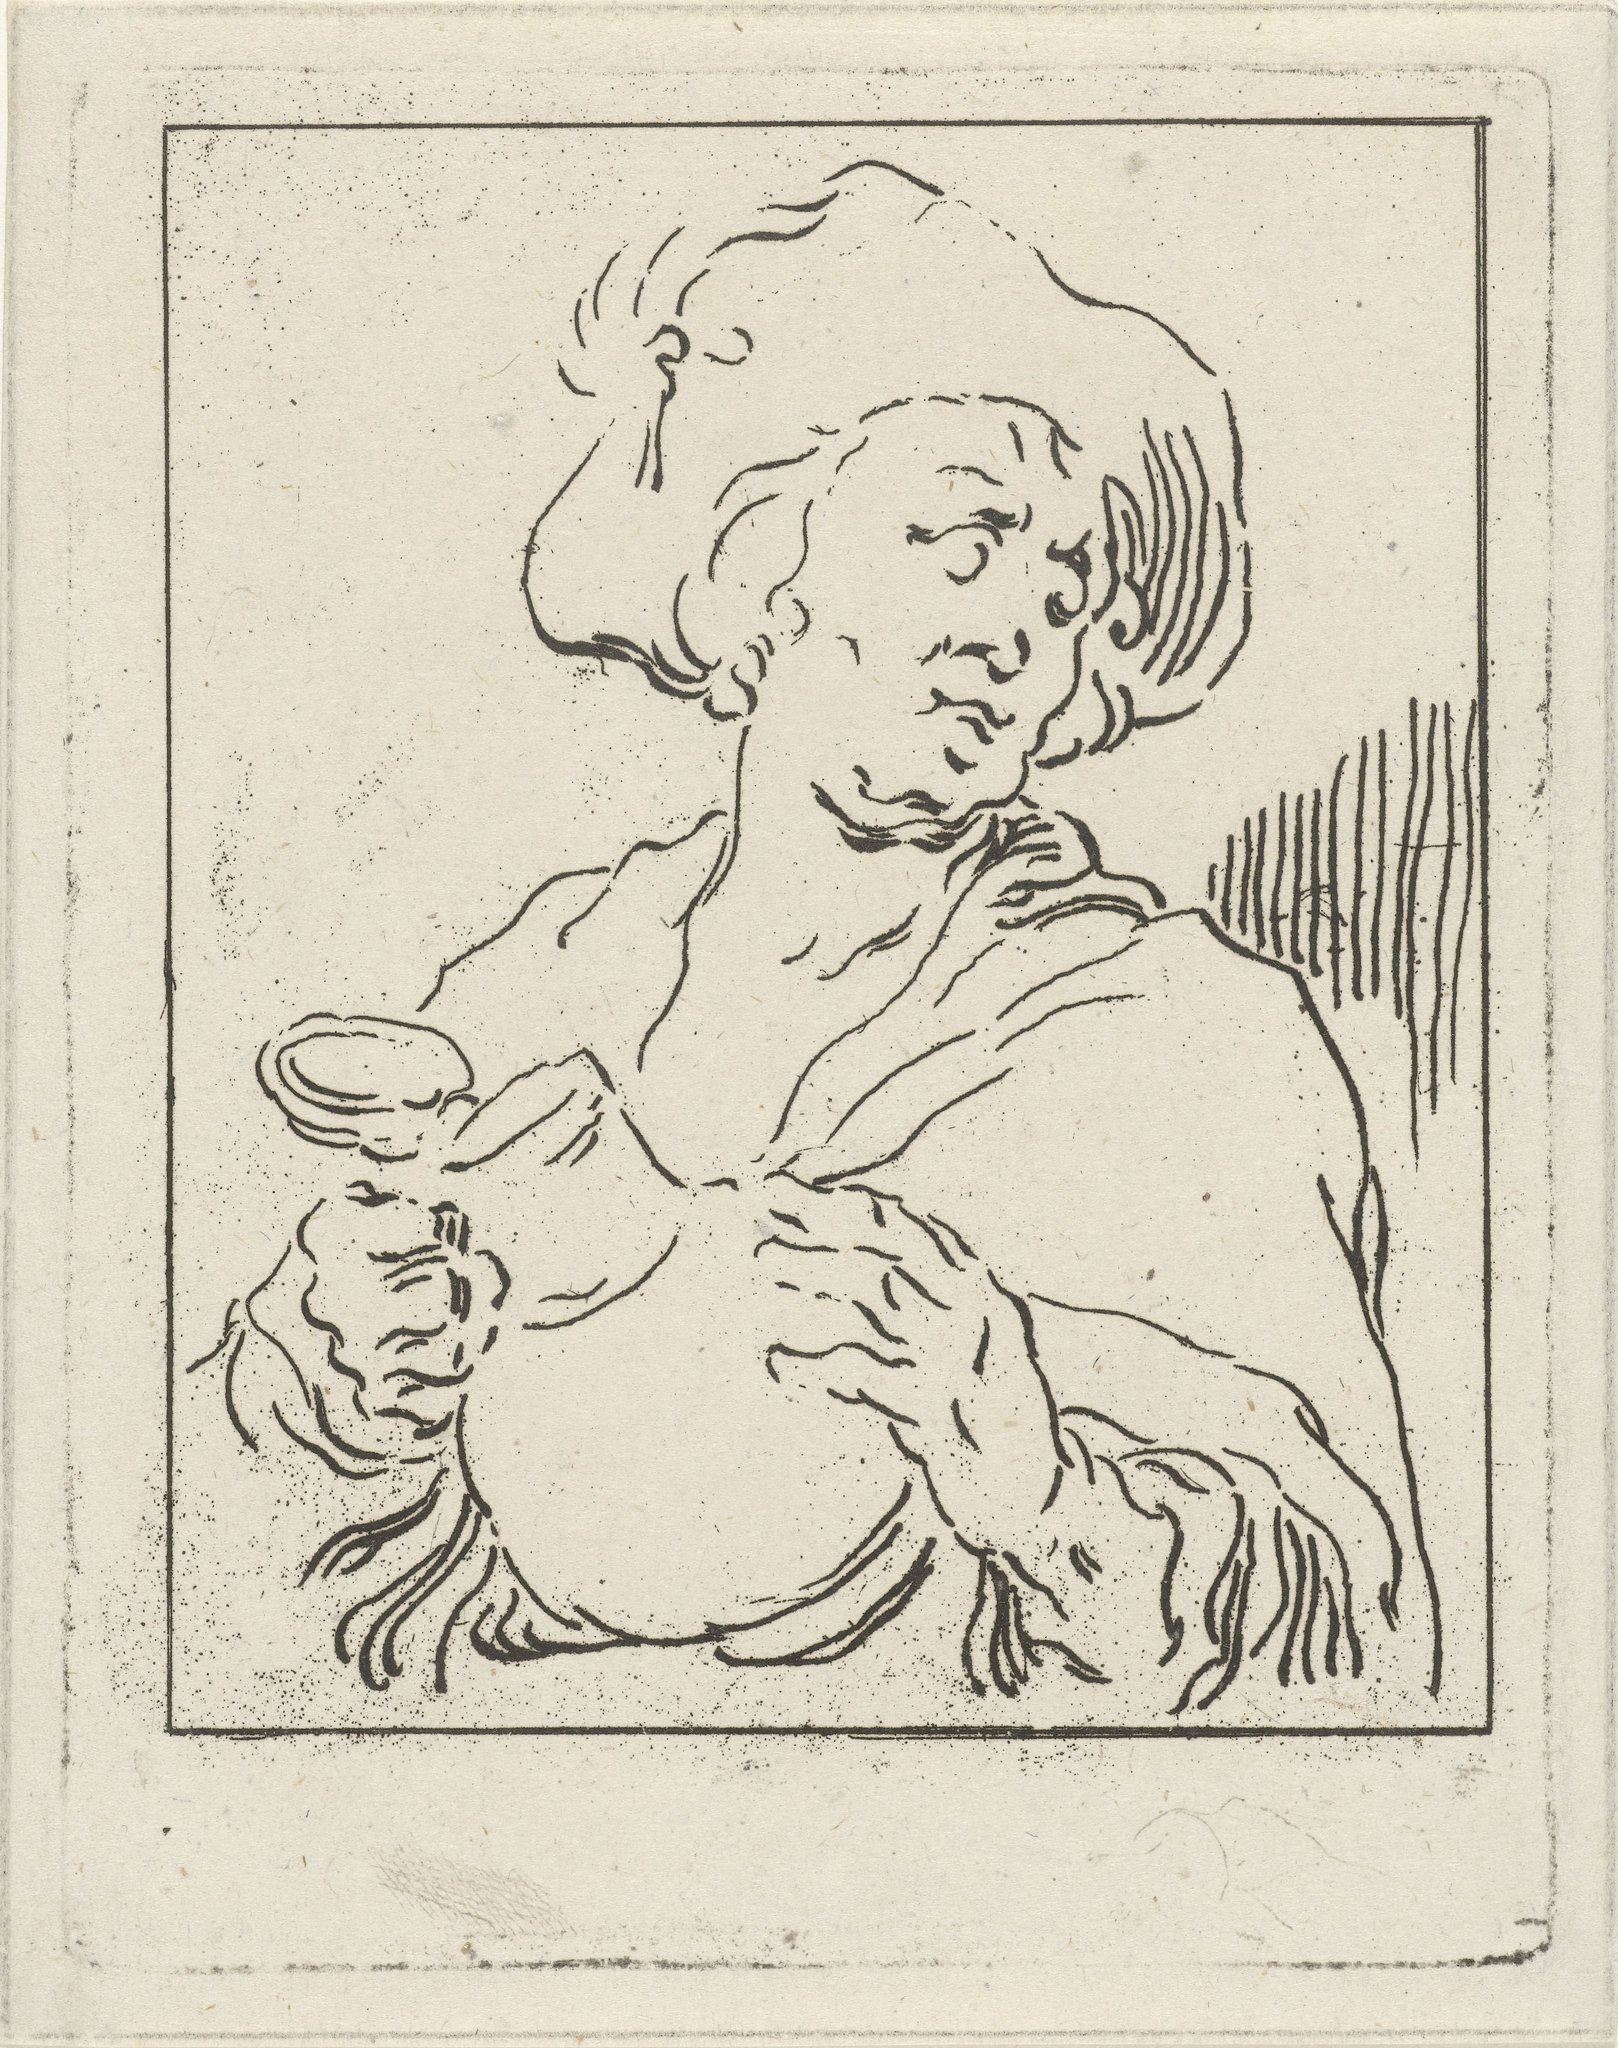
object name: print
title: Man met kruik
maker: hermanus fock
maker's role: conservator, draughtsman, painter, print maker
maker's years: 1766-1822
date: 1781-1822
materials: paper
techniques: etching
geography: amsterdam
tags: jar, jug (used as drinking-vessel)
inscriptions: collector's mark: Lugt 2228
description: Figuur, ten halven lijve, met gevederde hoed op het hoofd en een bierkruik in beide handen.